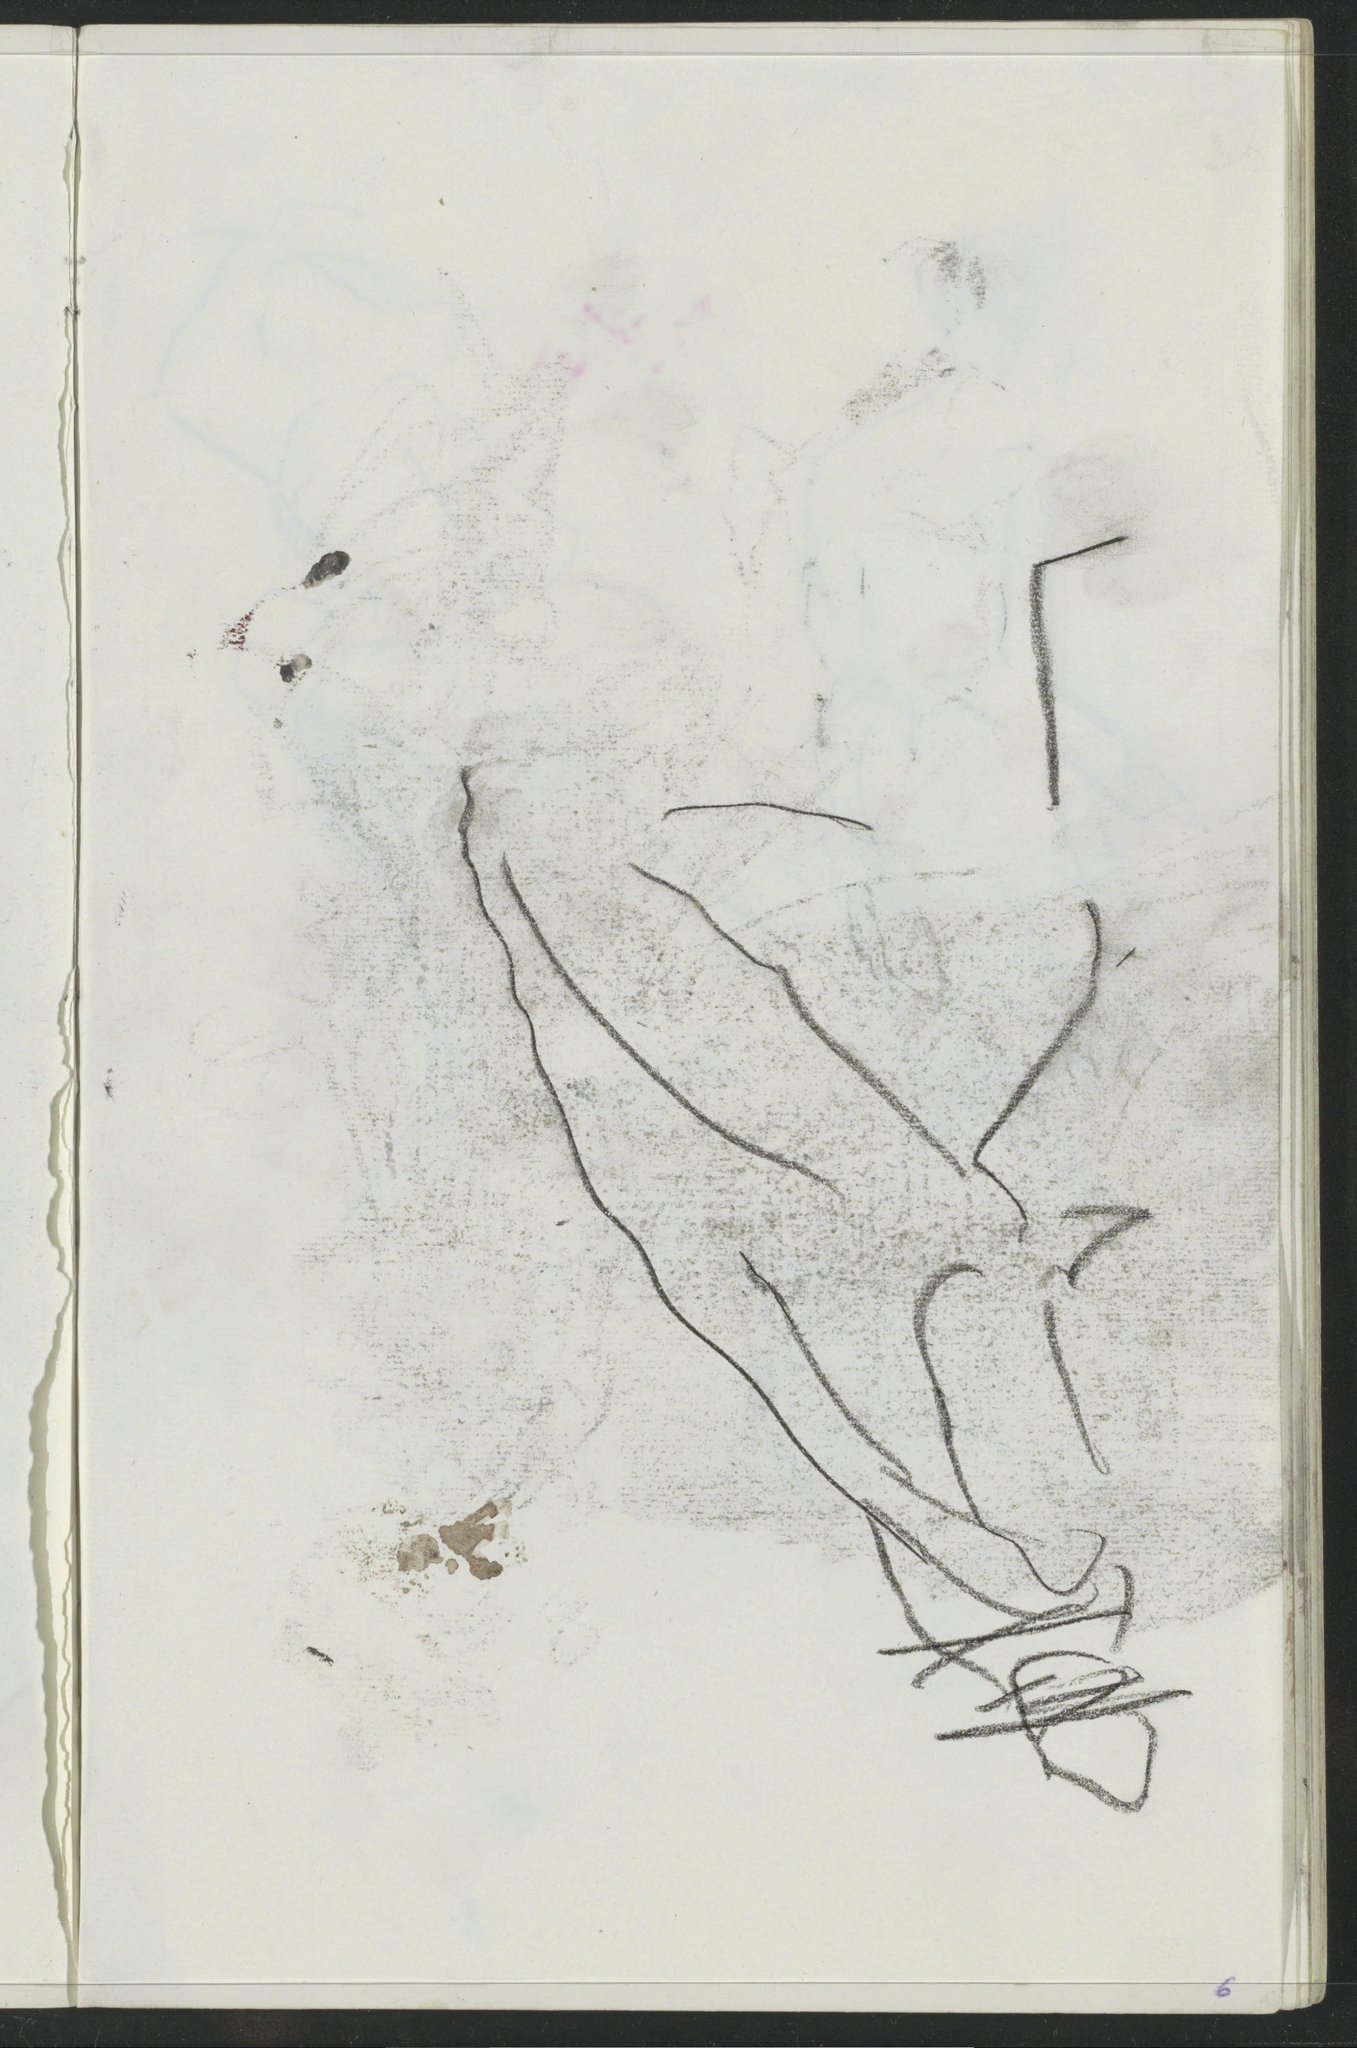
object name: sketchbook leaf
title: Studie, mogelijk een figuurstudie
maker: isaac israels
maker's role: draughtsman, painter, print maker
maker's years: 1865-1934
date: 1875-1934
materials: chalk, paper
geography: amsterdam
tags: the (nude) human figure; 'corpo humano' (ripa)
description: Blad 6 recto uit schetsboek XI met 30 bladen.